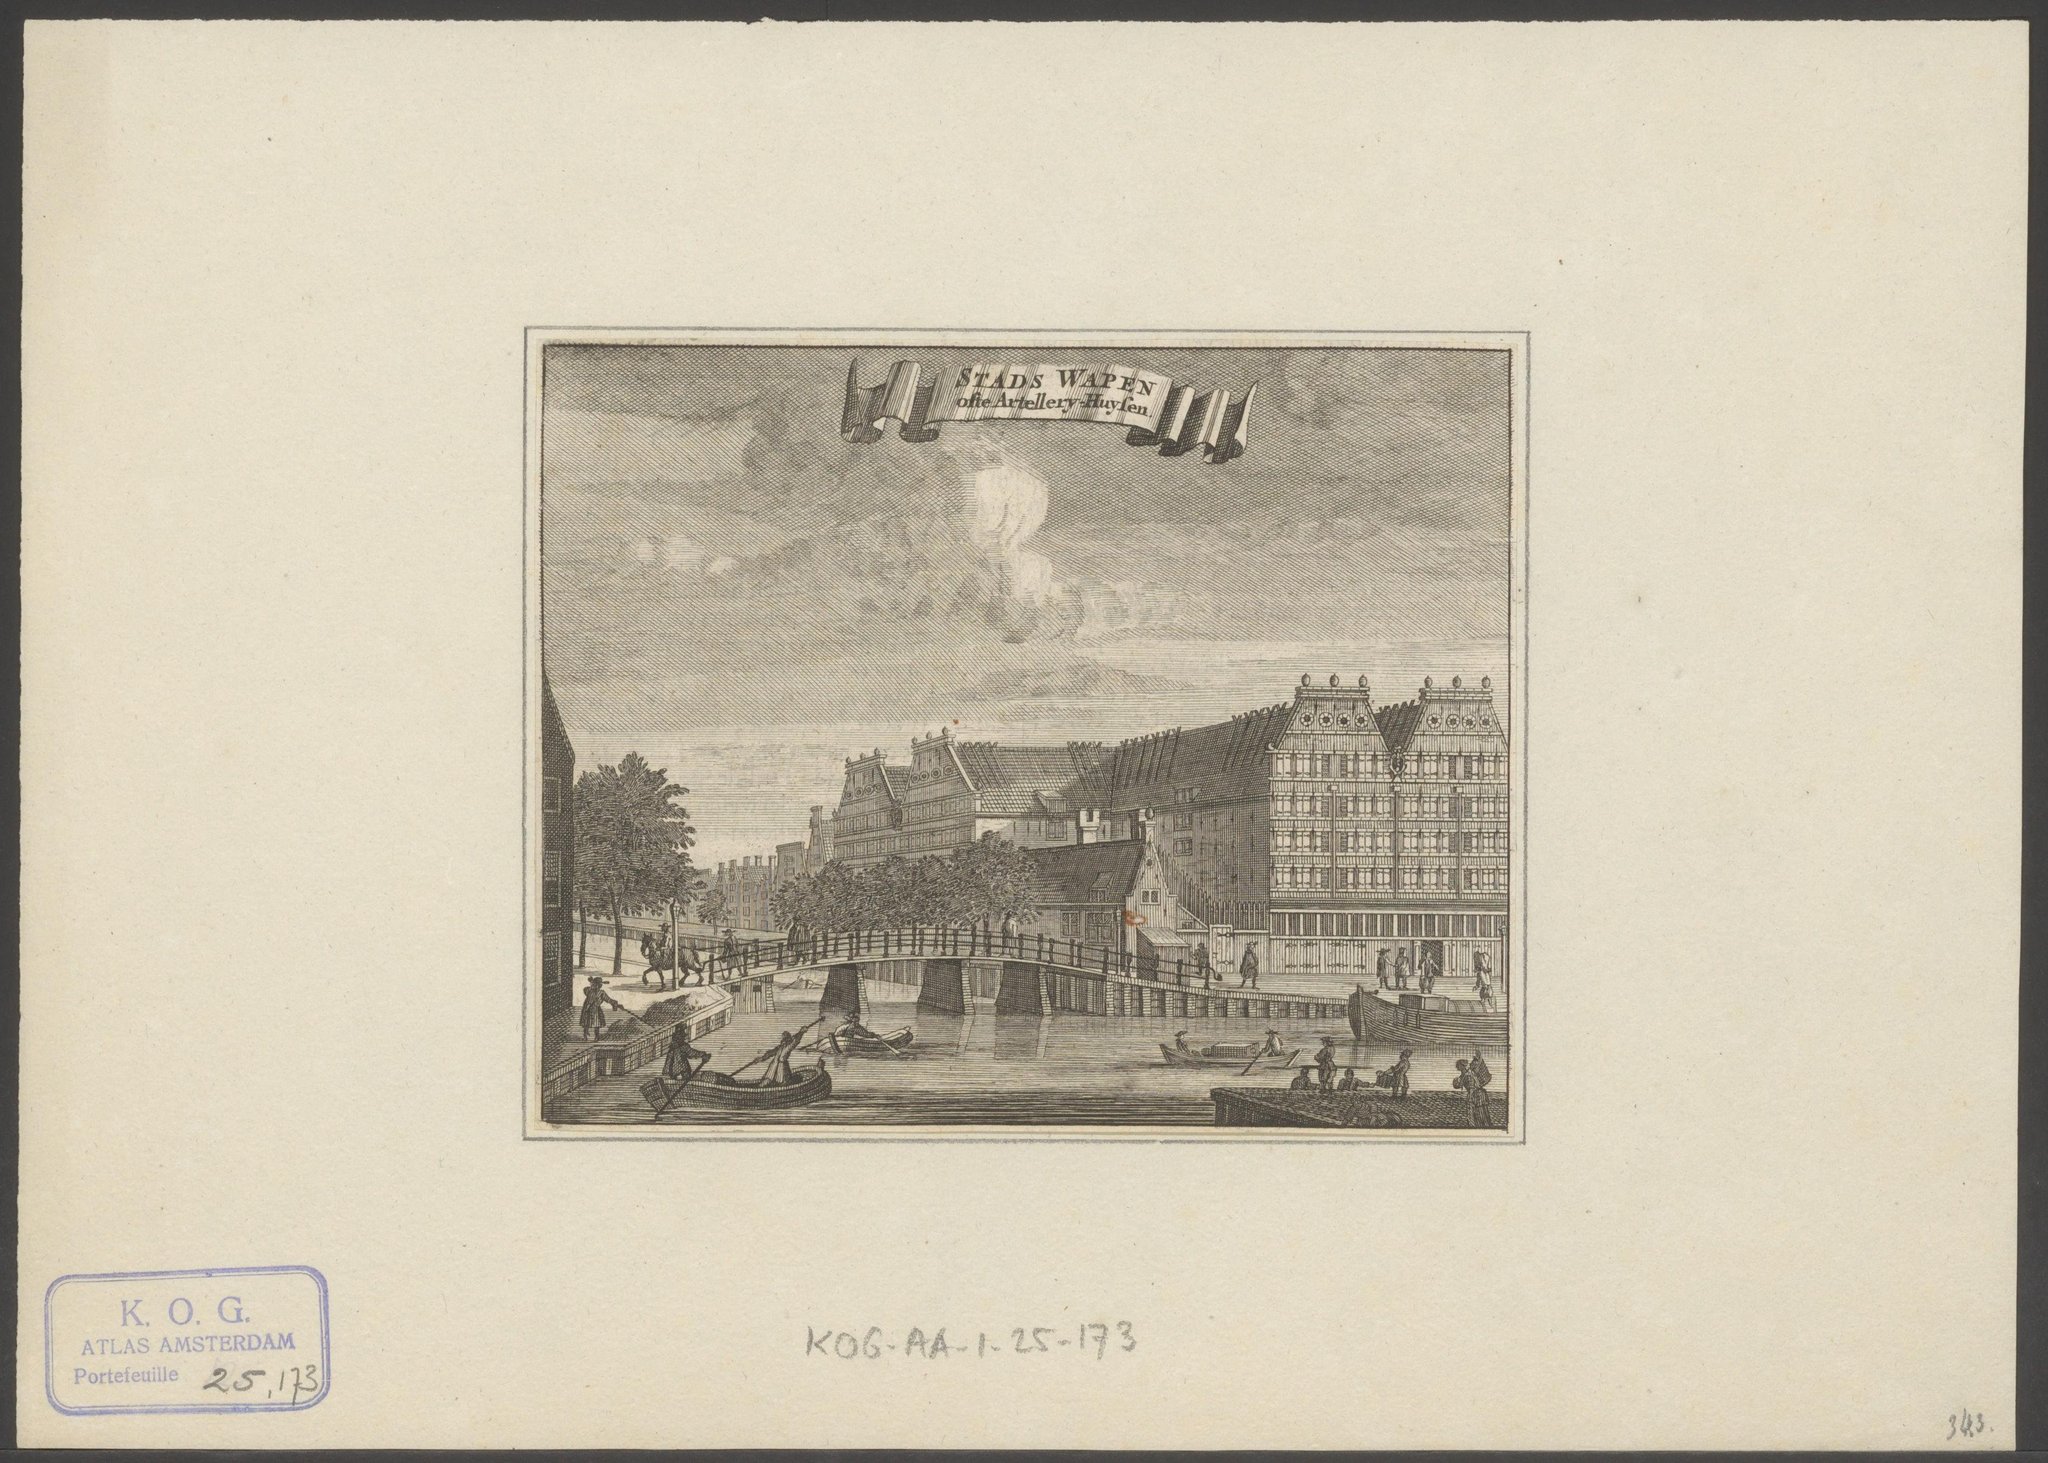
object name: print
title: Gezicht op de Stadskorenpakhuizen en de Stadsartilleriehuizen te Amsterdam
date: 1693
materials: paper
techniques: engraving, etching, letterpress printing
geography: amsterdam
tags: warehouse (~ harbour), large-scale structure for storage, e.g.: warehouse, depot, silo, bridge in city across river, canal, etc. (+ city(-scape) with figures, staffage), canals, waters (in city) (+ city(-scape) with figures, staffage), ammunition store, arsenal, street (+ city(-scape) with figures, staffage)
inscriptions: collector's mark: ‘25.173’ Lugt 1641b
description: Huidige staat van prent ook gebruikt in: Commelin, Caspar. Beschryvinge van Amsterdam, zynde een naukeurige verhandelinge van desselfs eerste oorspronk uyt (…). 2 dln. 2de druk. Amsterdam: Andries van Damme, Johannes Ratelband, weduwe A. van Aeltwyk en Hermanus Uytwerf, 1726. Eerdere staat van prent ook gebruikt in: Commelin, Caspar. Beschryvinge van Amsterdam, desselfs eerste oorspronk uyt den Huyse (…). 2 dln. Amsterdam: Abraham Wolfgang, Gillis Janssonius van Waesberge, Johannes Janssonius van Waesberge II, weduwe Dirk Boom I, Hendrick Boom en Rembertus Goethals, 1693. En in: Commelin, Caspar. Beschryvinge van Amsterdam, zynde een naukeurige verhandelinge van desselfs eerste oorspronk uyt (…). 2 dln. Amsterdam: weduwe Aart Dircksz Oossaan, 1694.